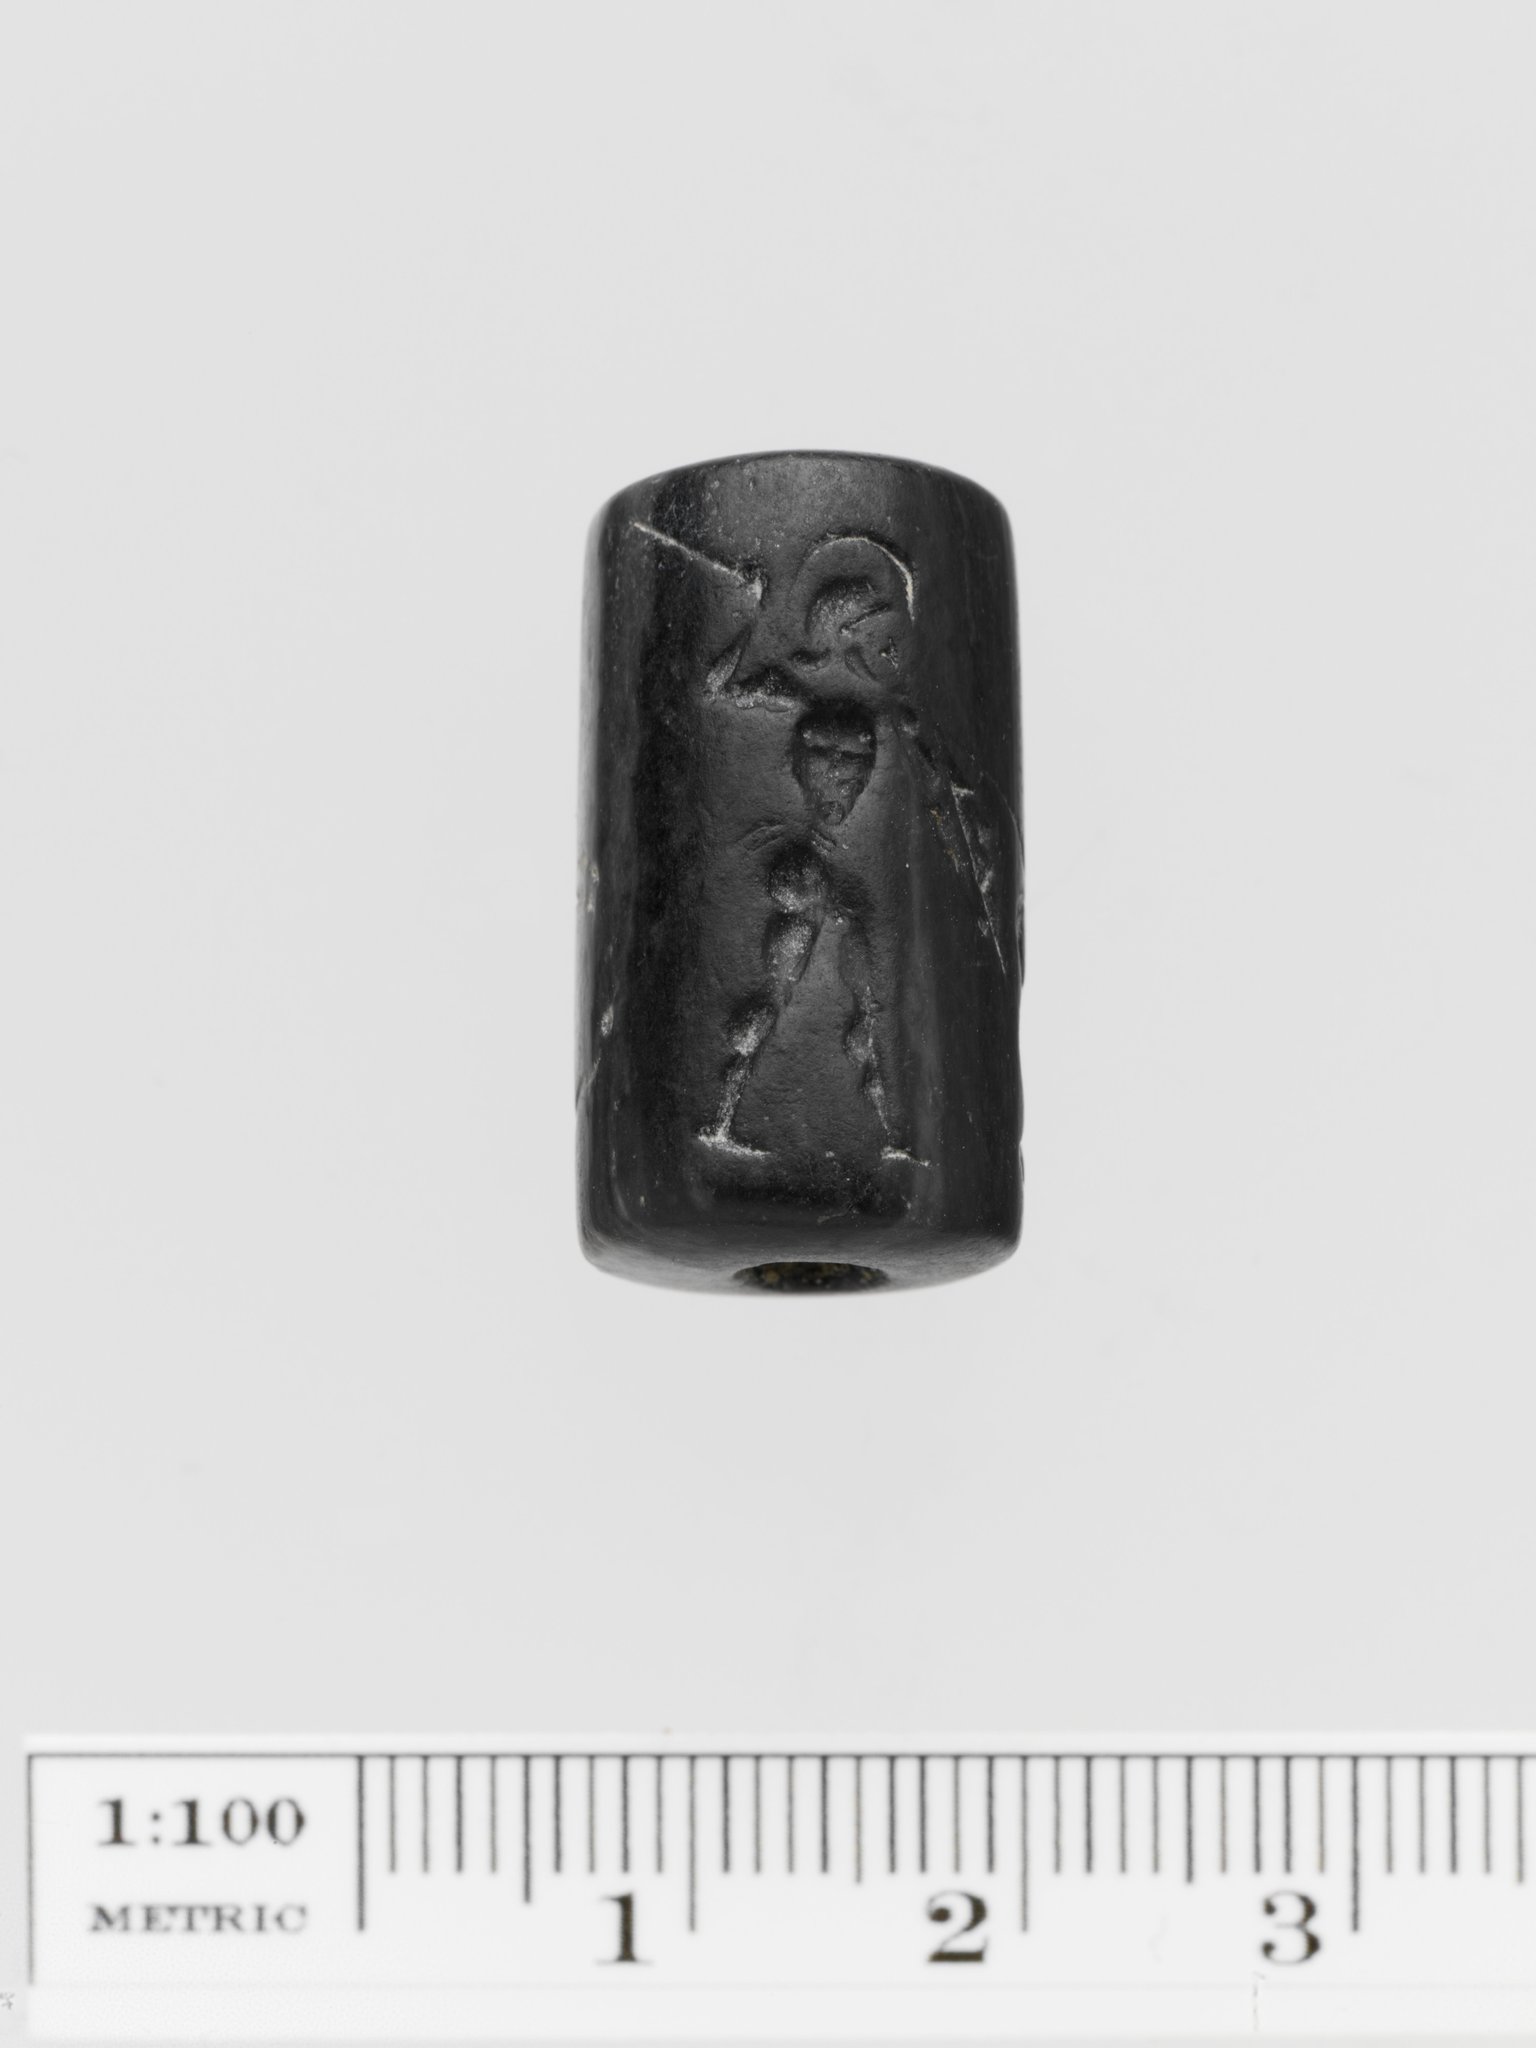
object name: cylinder seal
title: Black marble cylinder seal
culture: greek, ionian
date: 500-401 BCE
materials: marble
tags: soldiers,male nudes,deer,lions